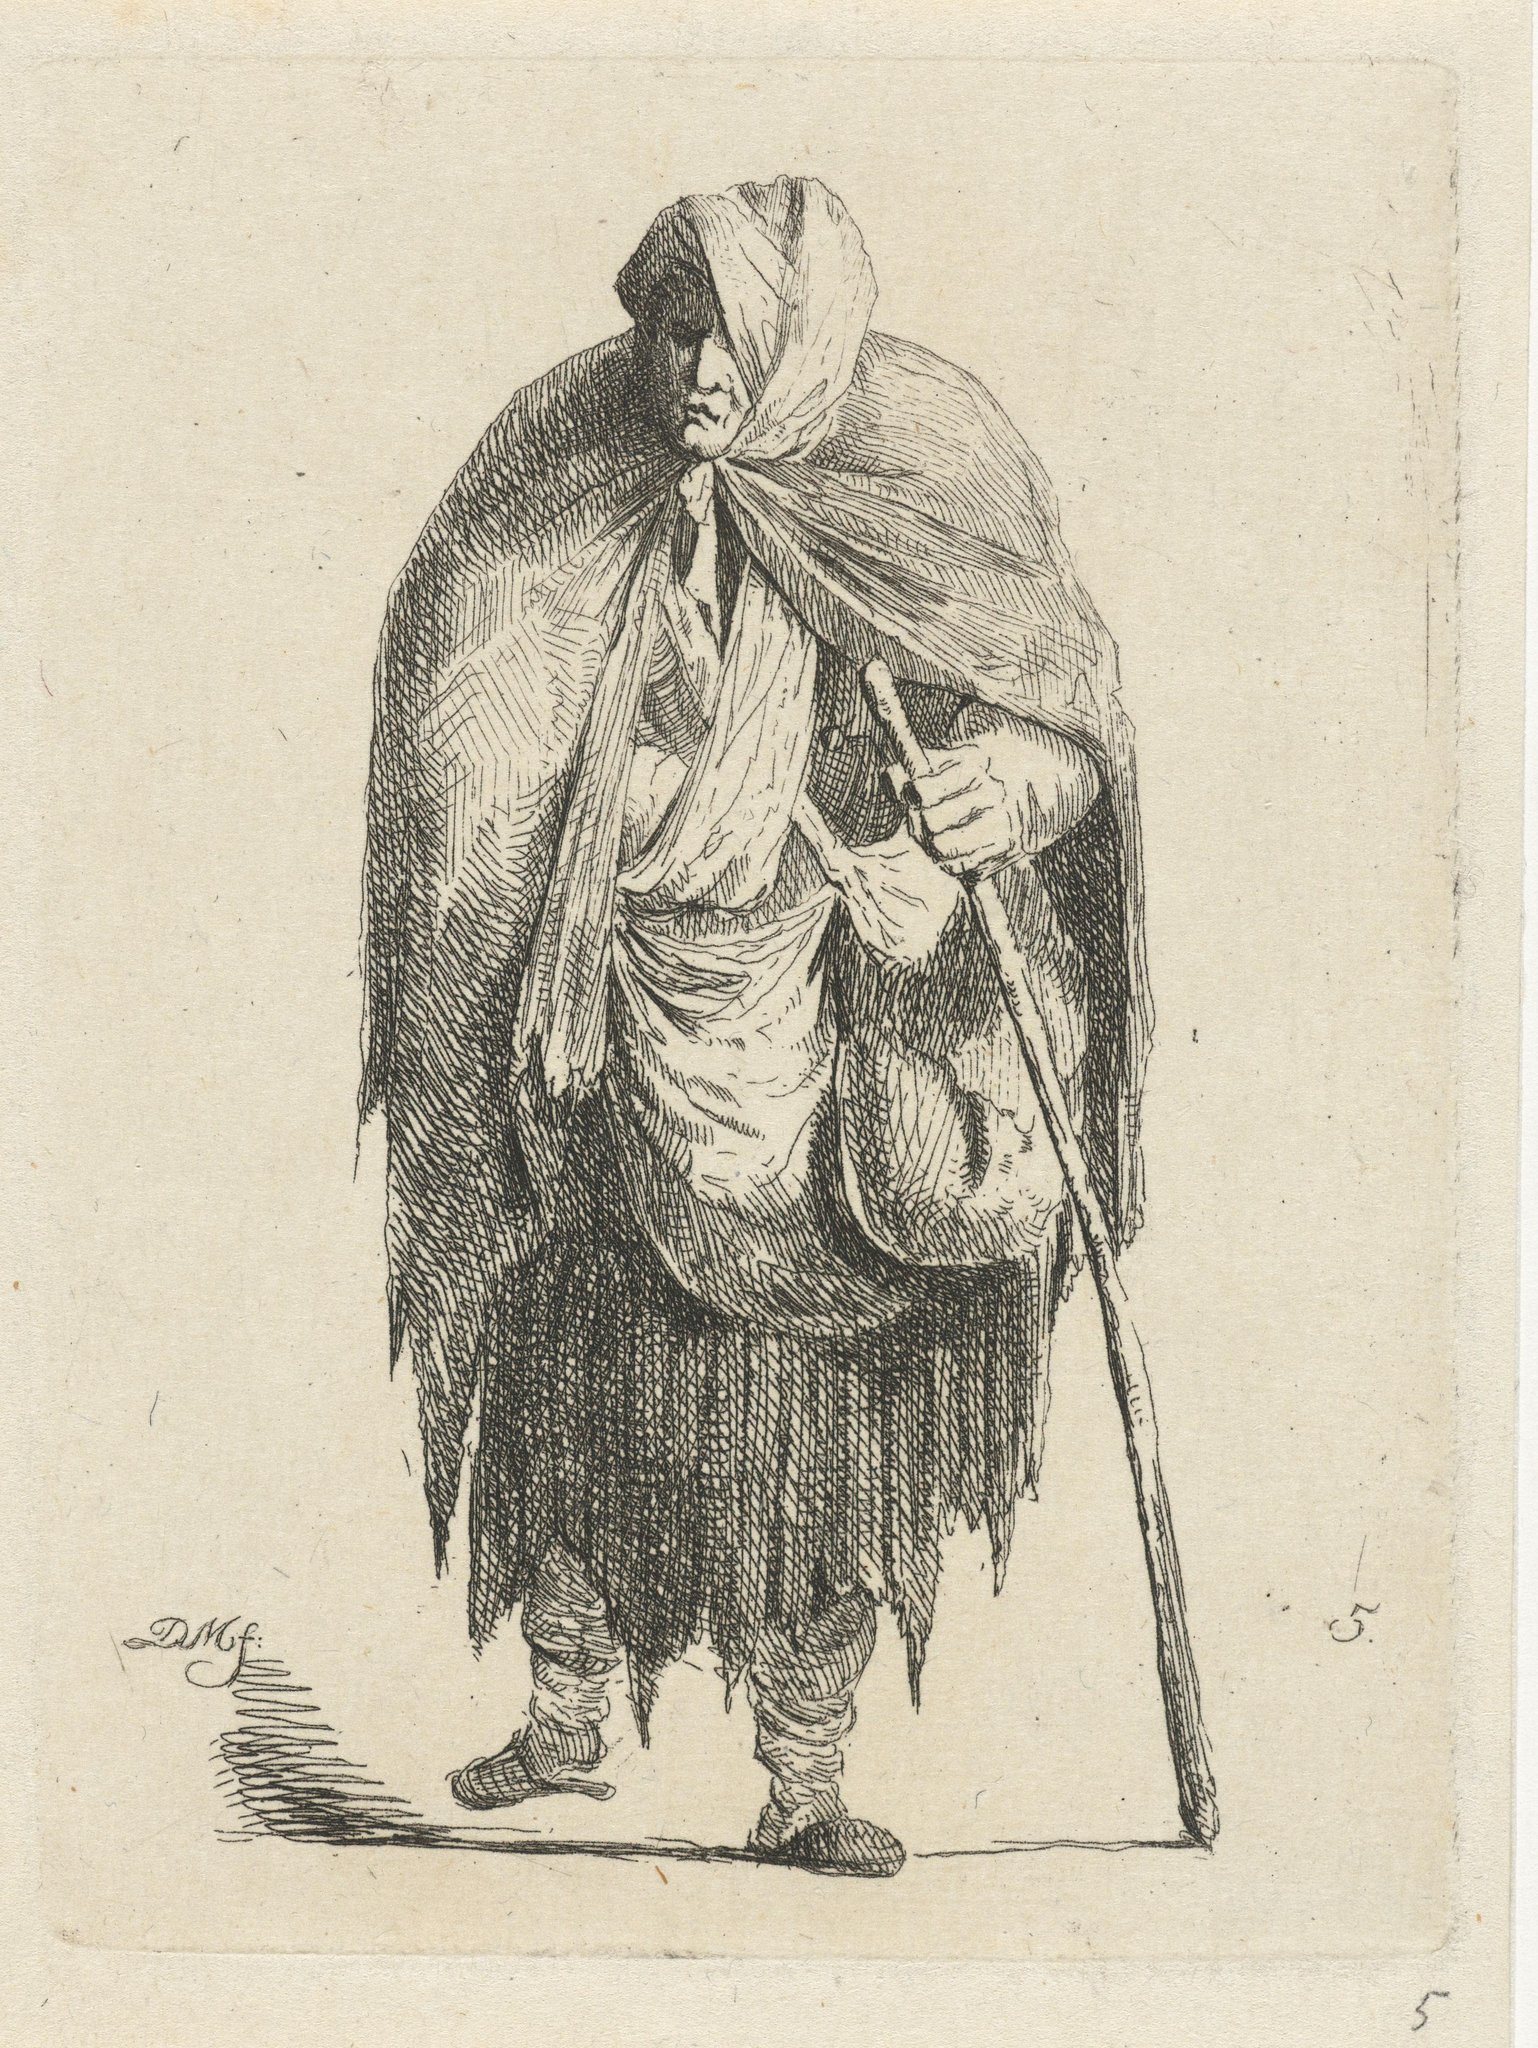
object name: print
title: Vrouw in lompen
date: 1803-1842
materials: paper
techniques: etching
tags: the poor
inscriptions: collector's mark: Lugt 2227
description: Een vrouw in lompen gehuld met een stok in haar hand en een tas over haar schouder. Rechtsonder: 5.